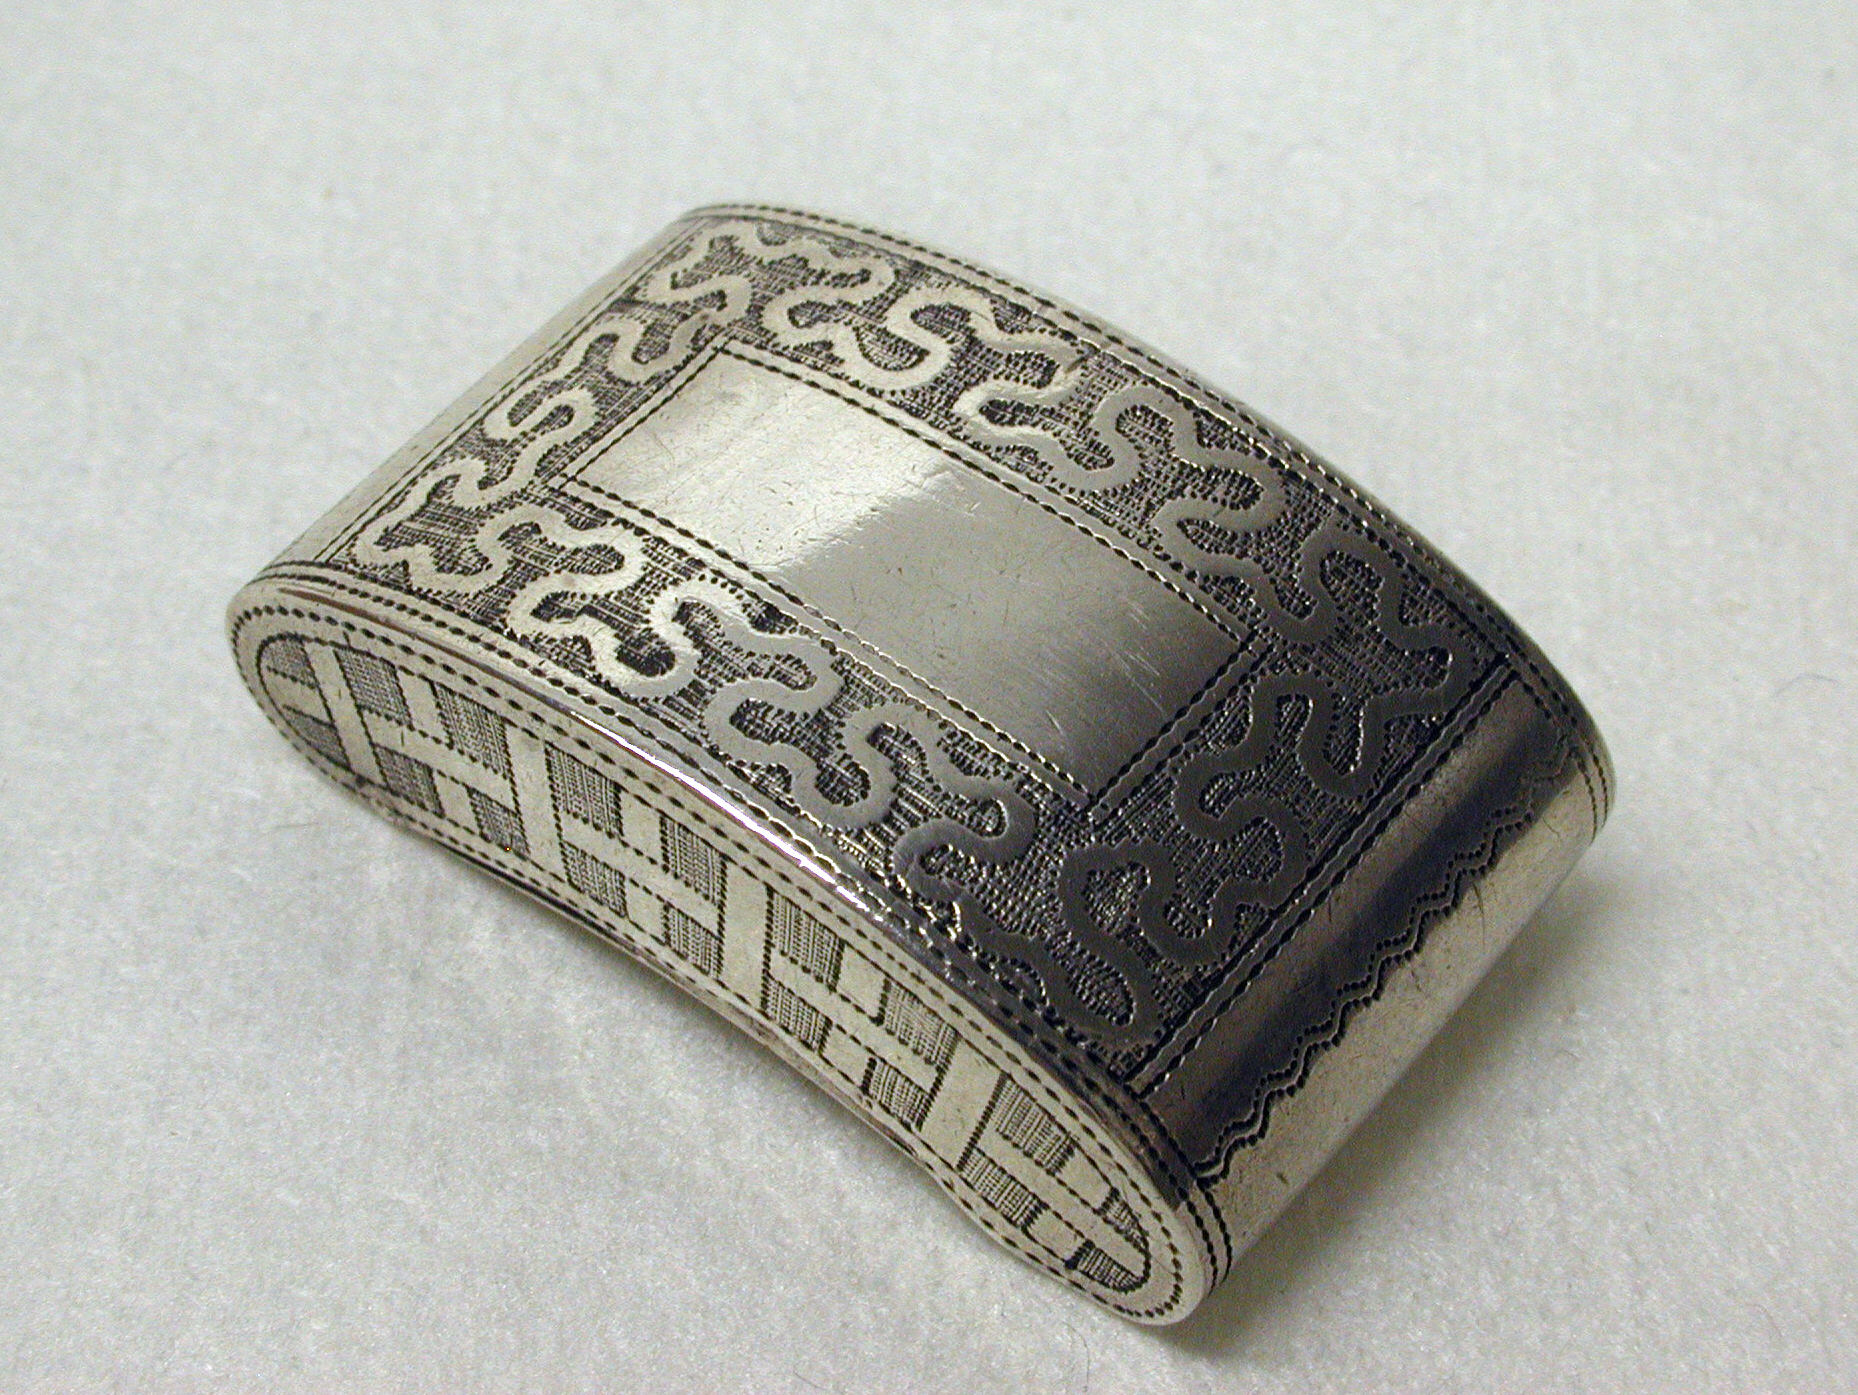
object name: snuffbox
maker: joseph taylor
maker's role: maker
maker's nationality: british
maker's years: 1767-1827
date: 1808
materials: silver